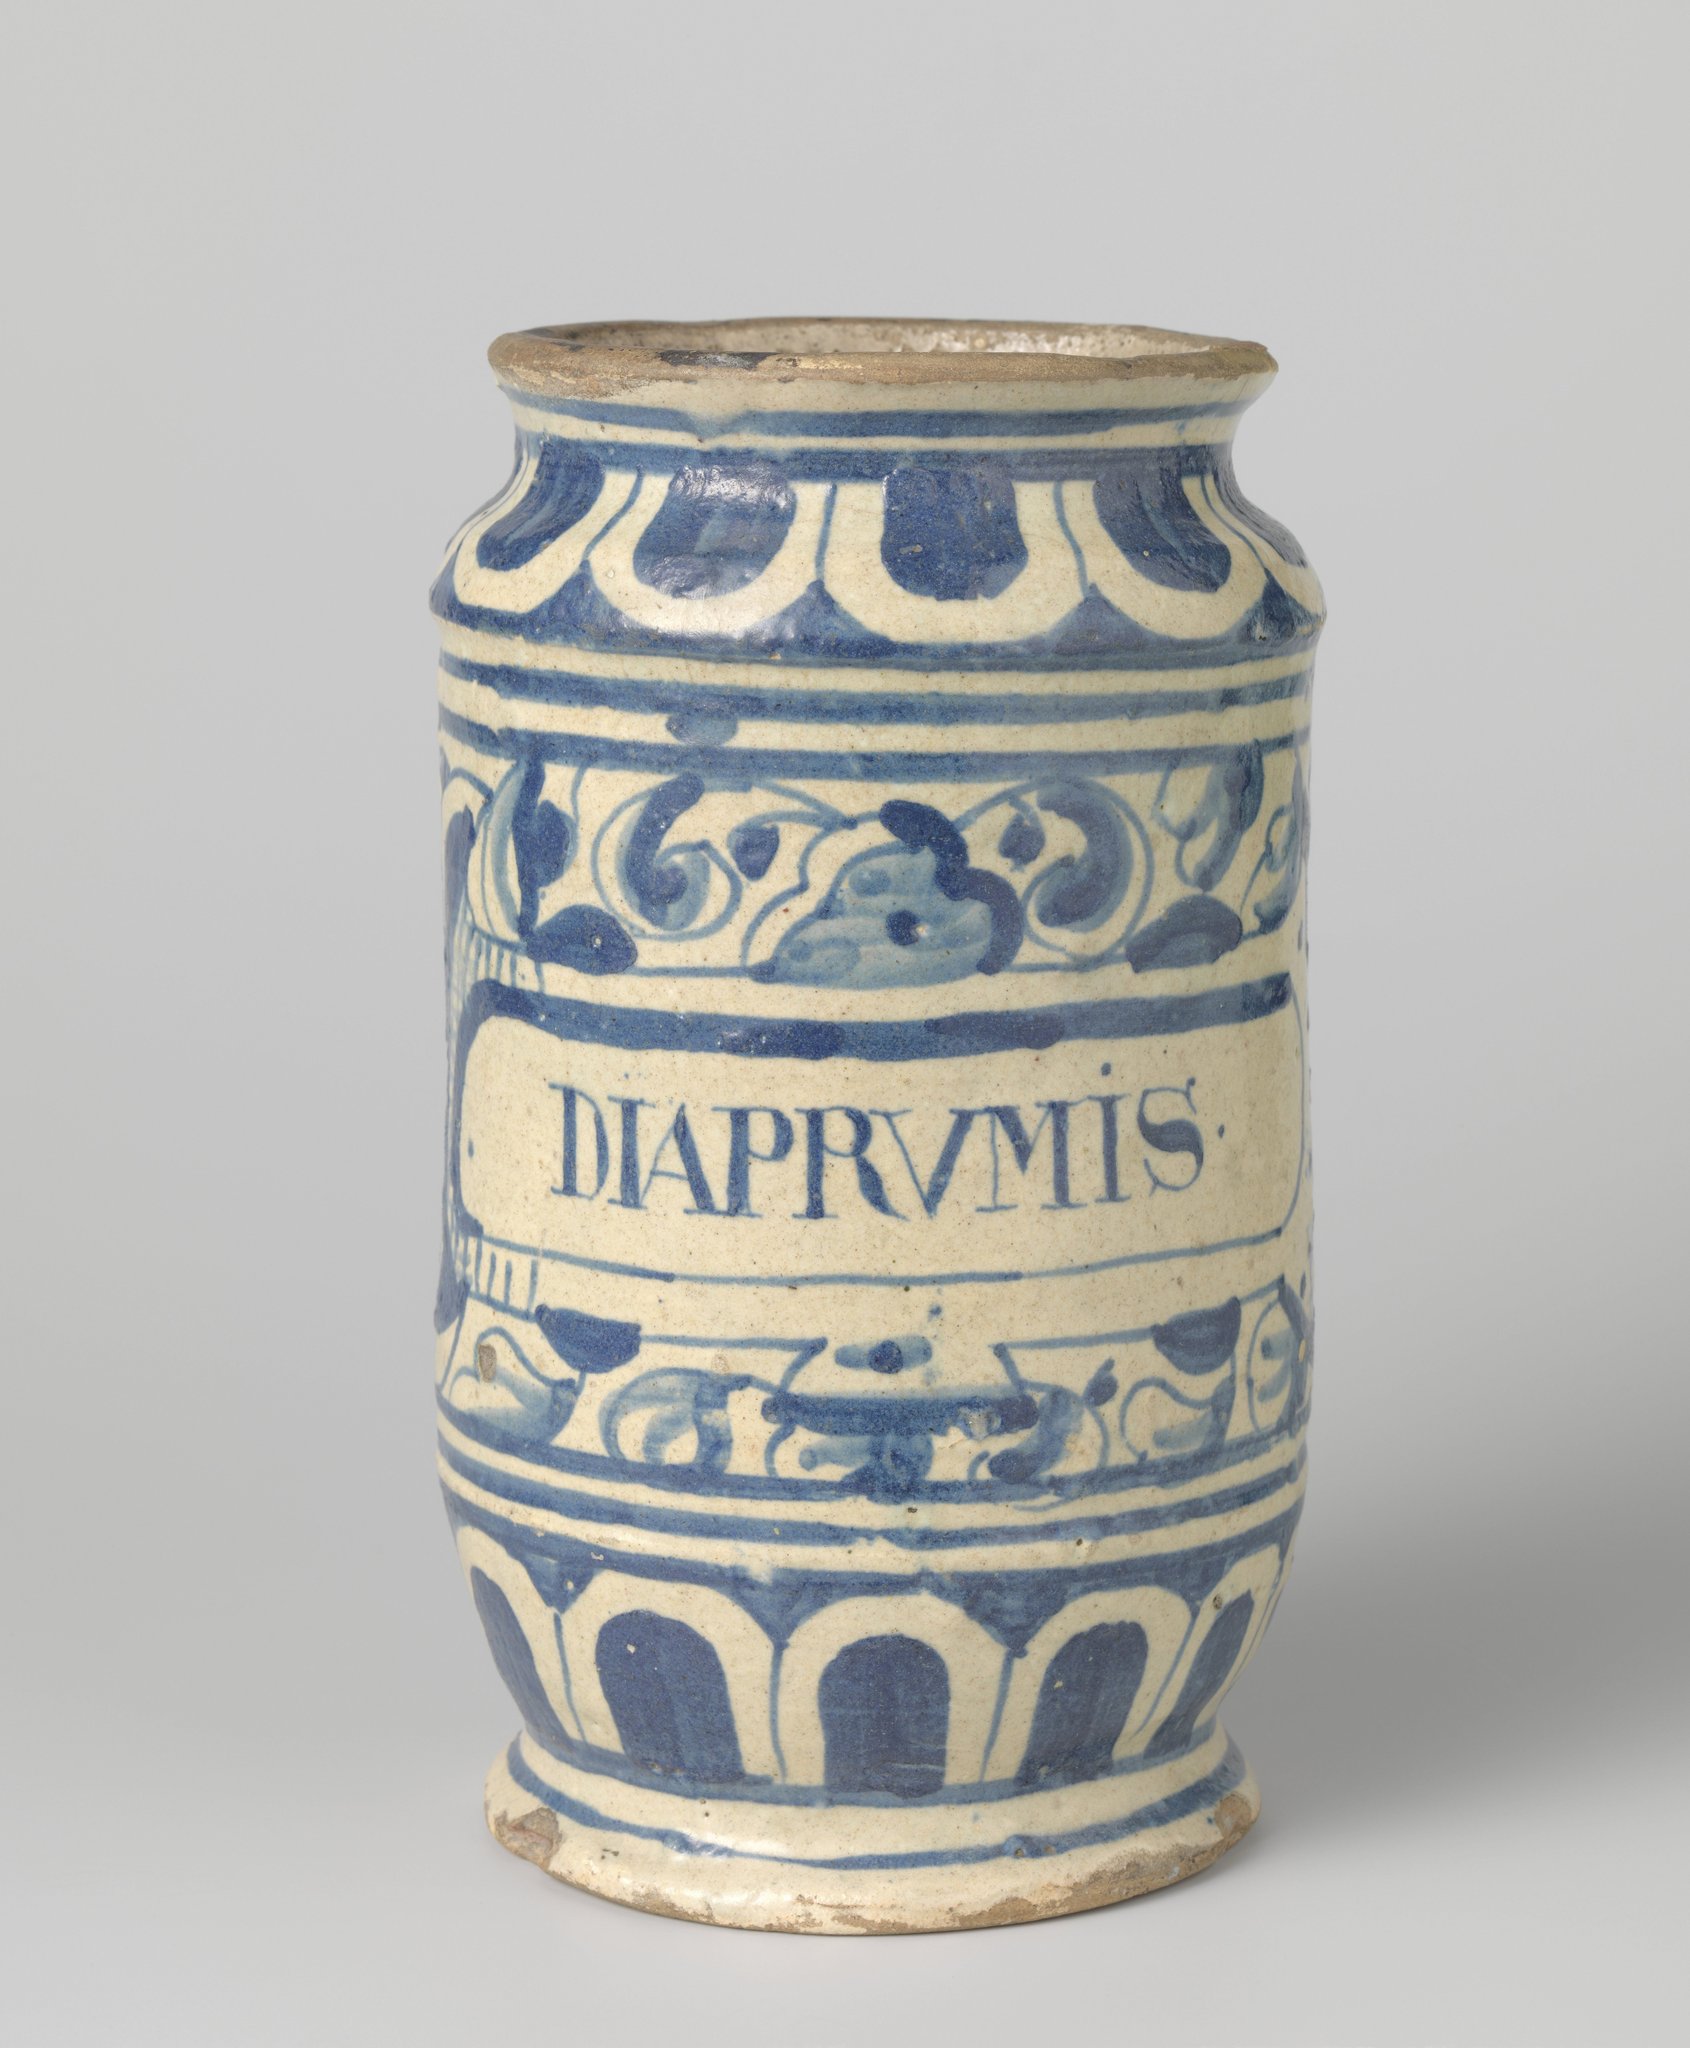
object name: apothecary jar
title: Apothecary jar (<albarello>)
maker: Anonymous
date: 1610-1635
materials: earthenware, glaze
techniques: maiolica, painted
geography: netherlands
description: translation of inscription: prune laxative